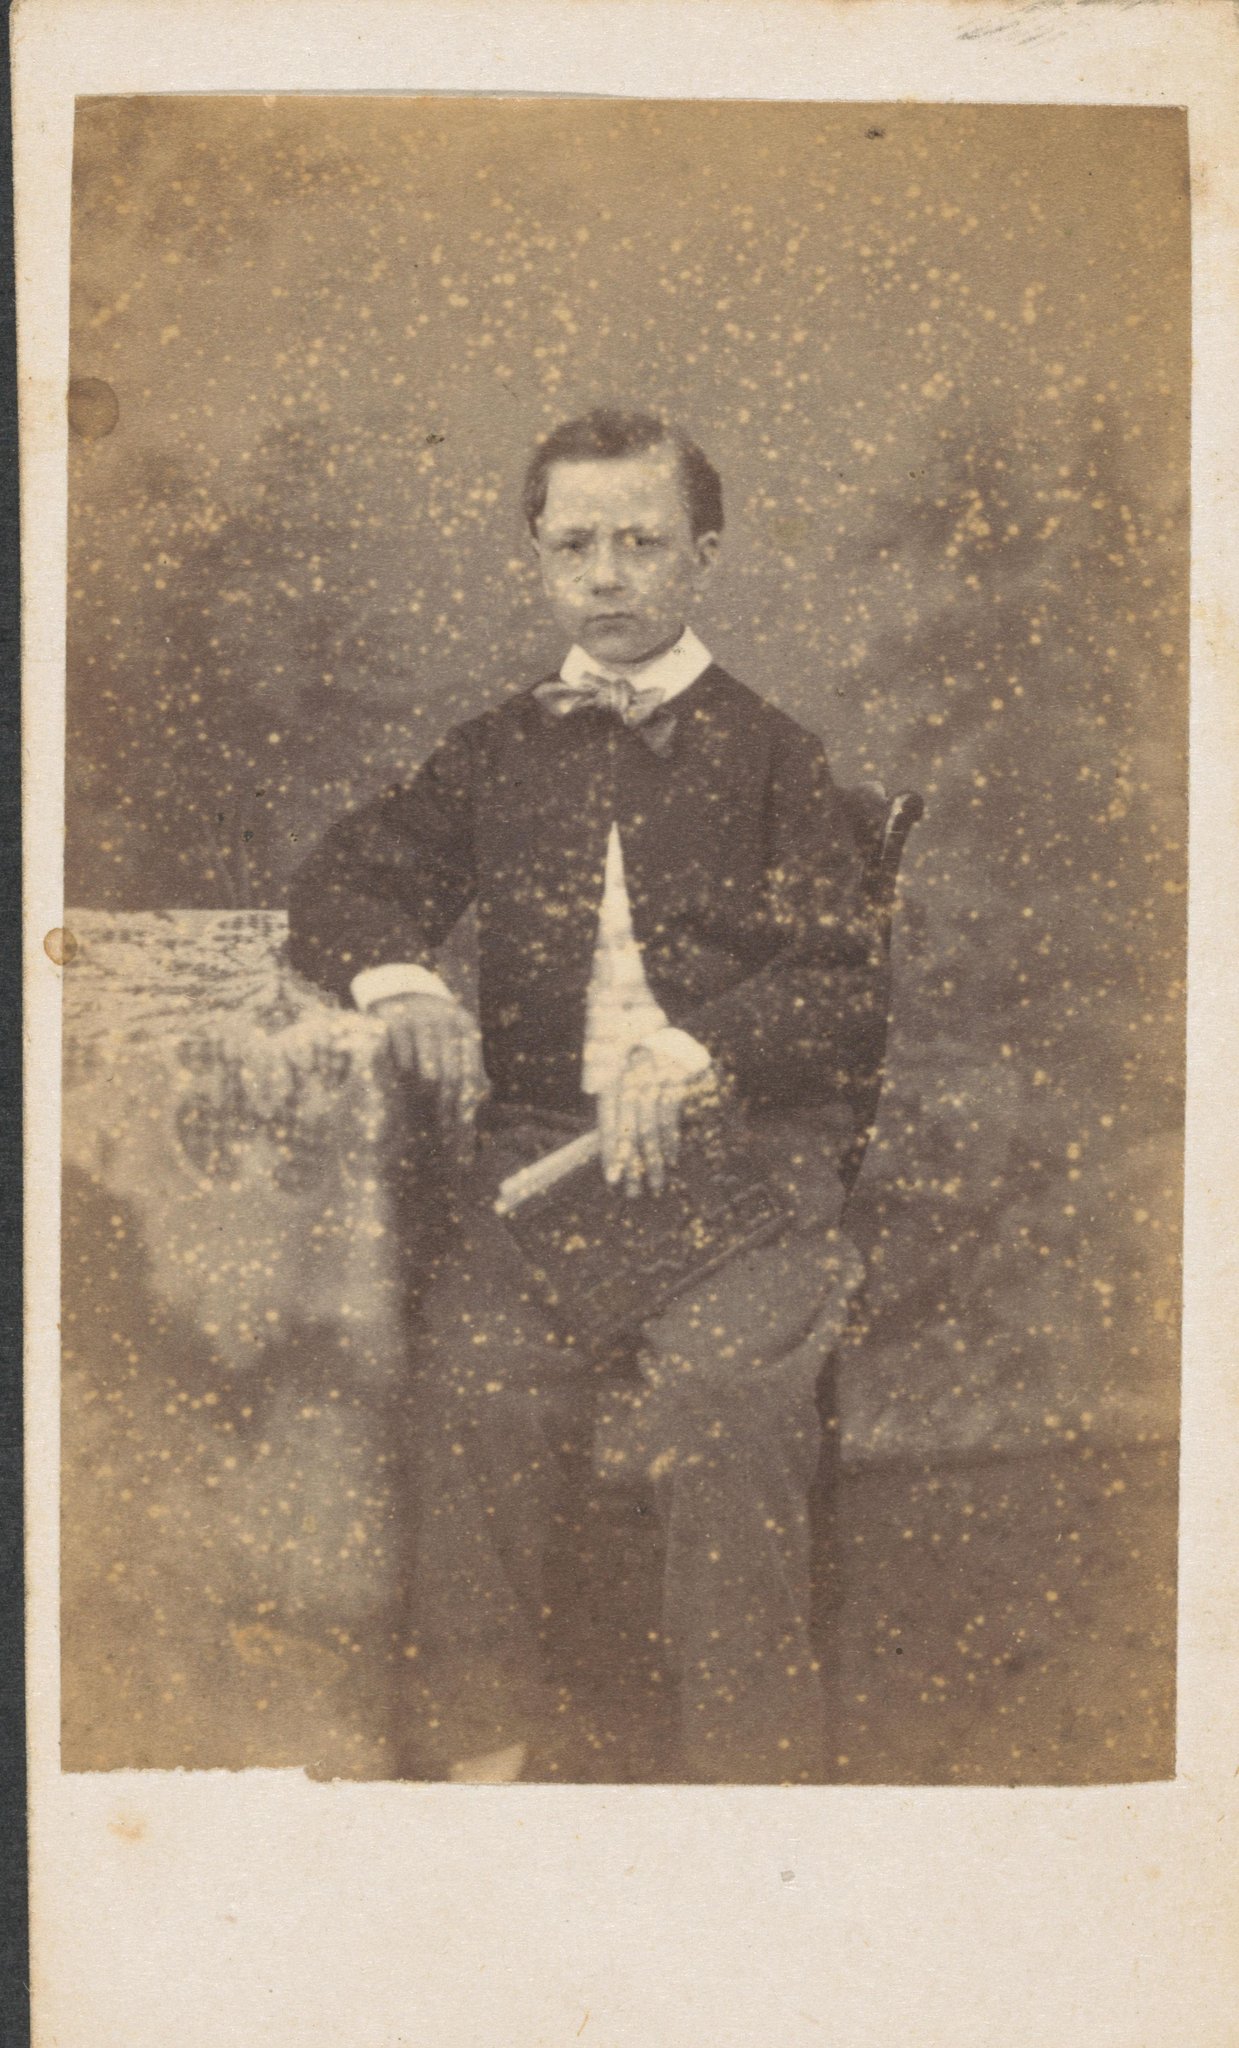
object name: photograph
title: Portret van een onbekende jongen uit de familie Marmelstein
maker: j. wijnman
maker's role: fotograaf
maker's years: 1844-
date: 1866-1870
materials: cardboard, photographic support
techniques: albumen print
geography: amsterdam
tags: child, historical persons not known by name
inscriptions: address: ‘PHOTOGRAPHISCH ATELIER./ J. WIJNMAN/ Halsteeg No. 248./ Amsterdam.’